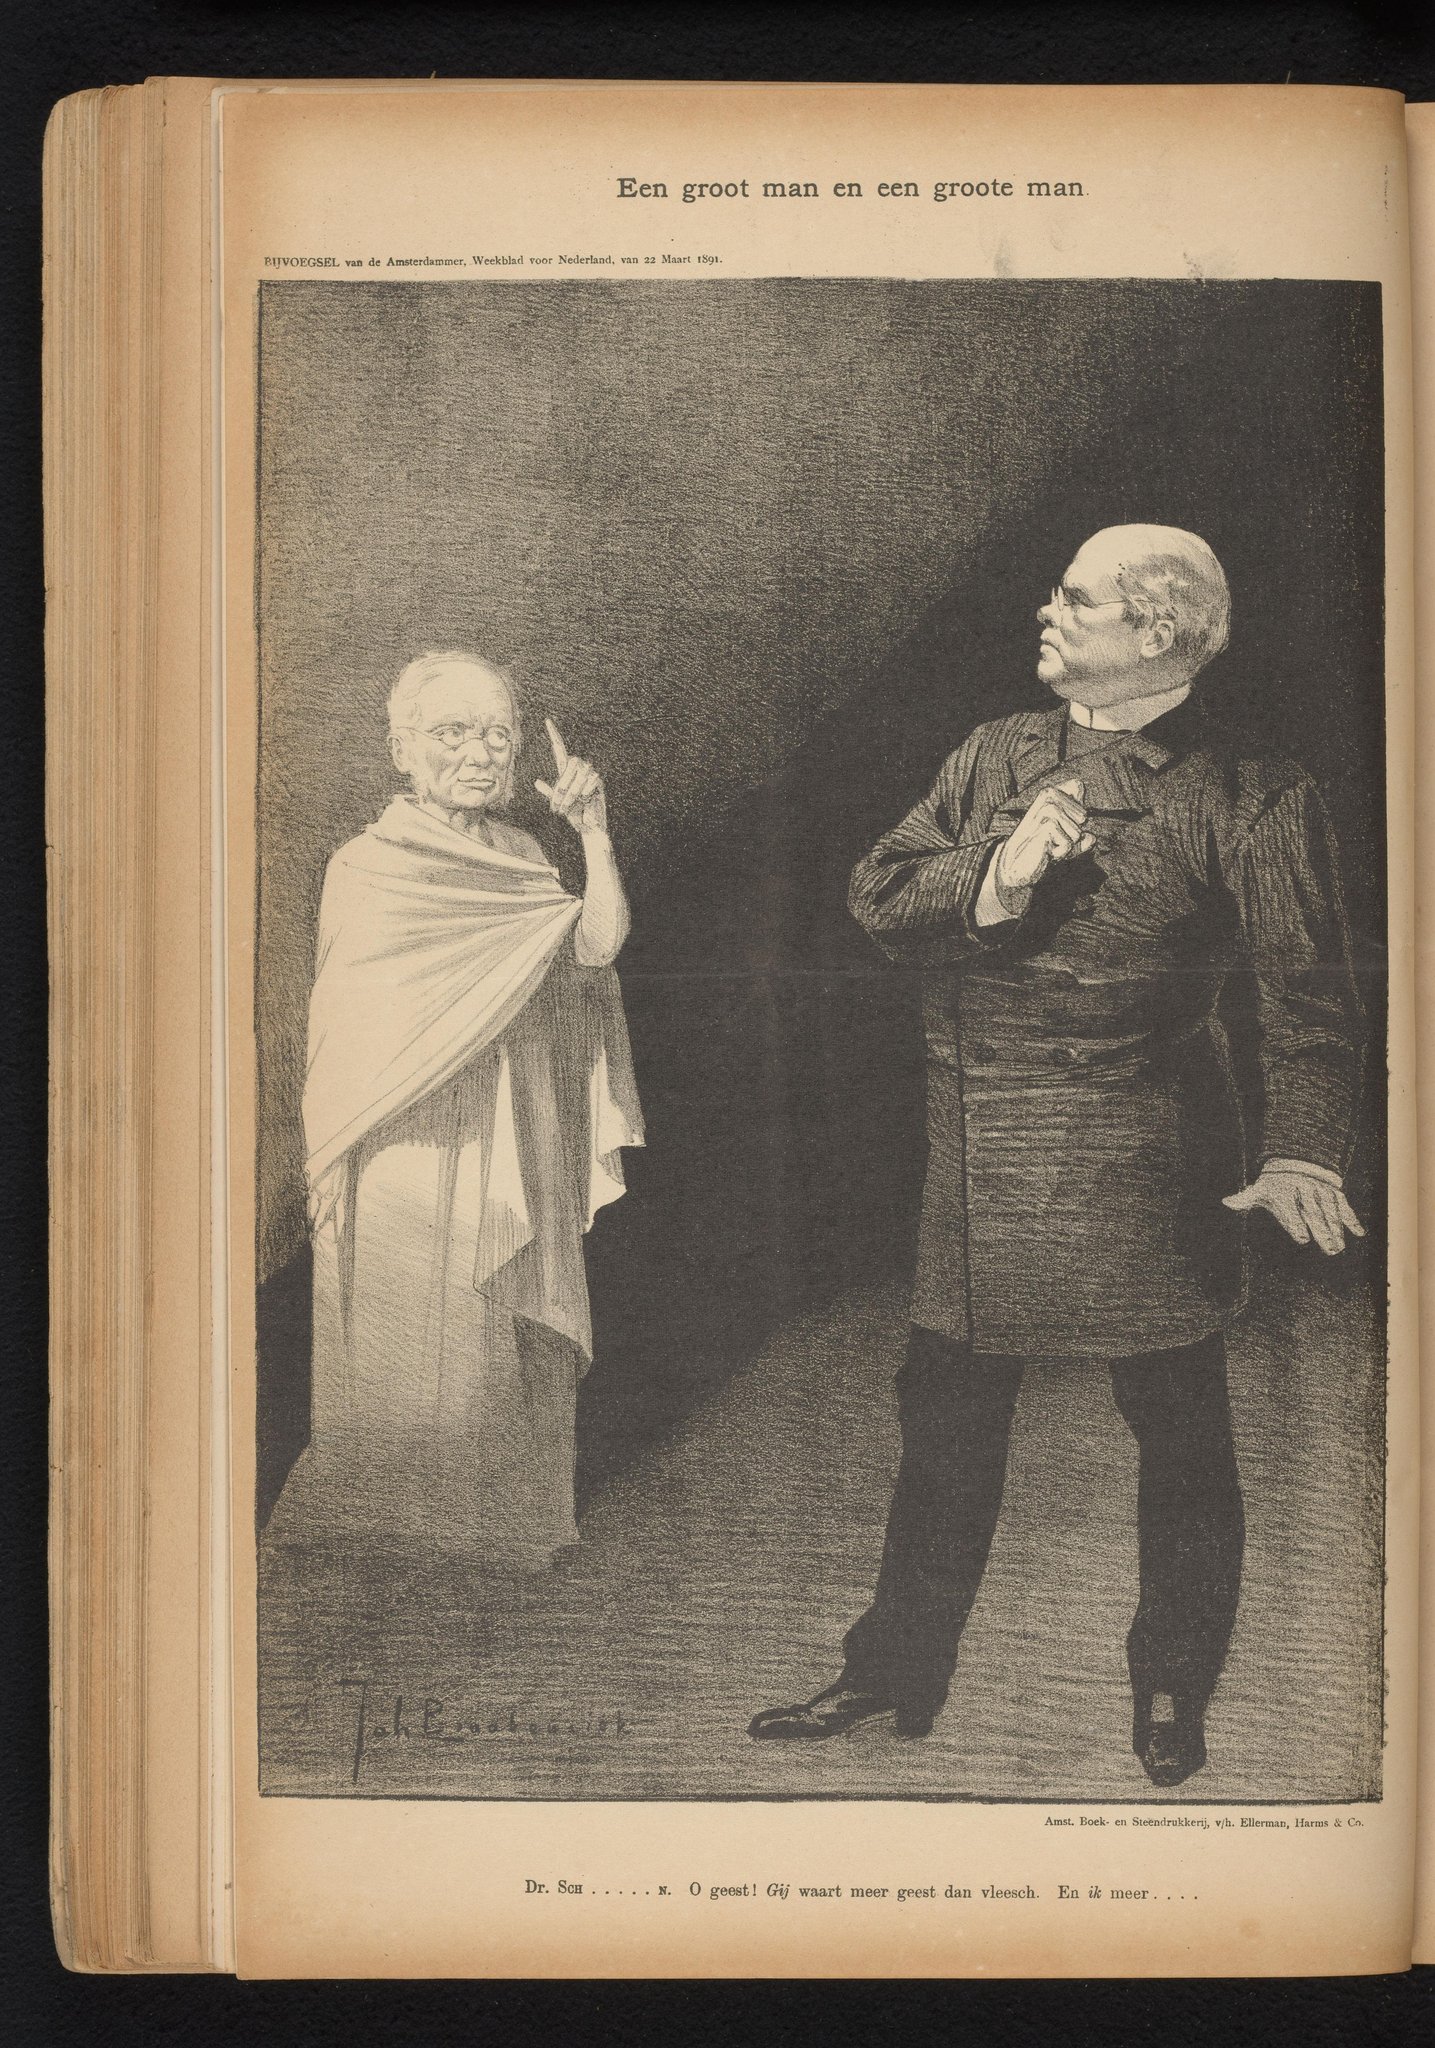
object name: cartoon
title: Een groot man en een groote man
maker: johan braakensiek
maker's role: draughtsman, print maker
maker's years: 1858-1940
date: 1891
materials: paper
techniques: lithograph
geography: netherlands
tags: rome, priest, herman johannes aloysius maria schaepman, voting, election, political caricatures and satires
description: Dr. Herman Schaepman ziet de geest van een (onbekende) politicus uit het verleden.